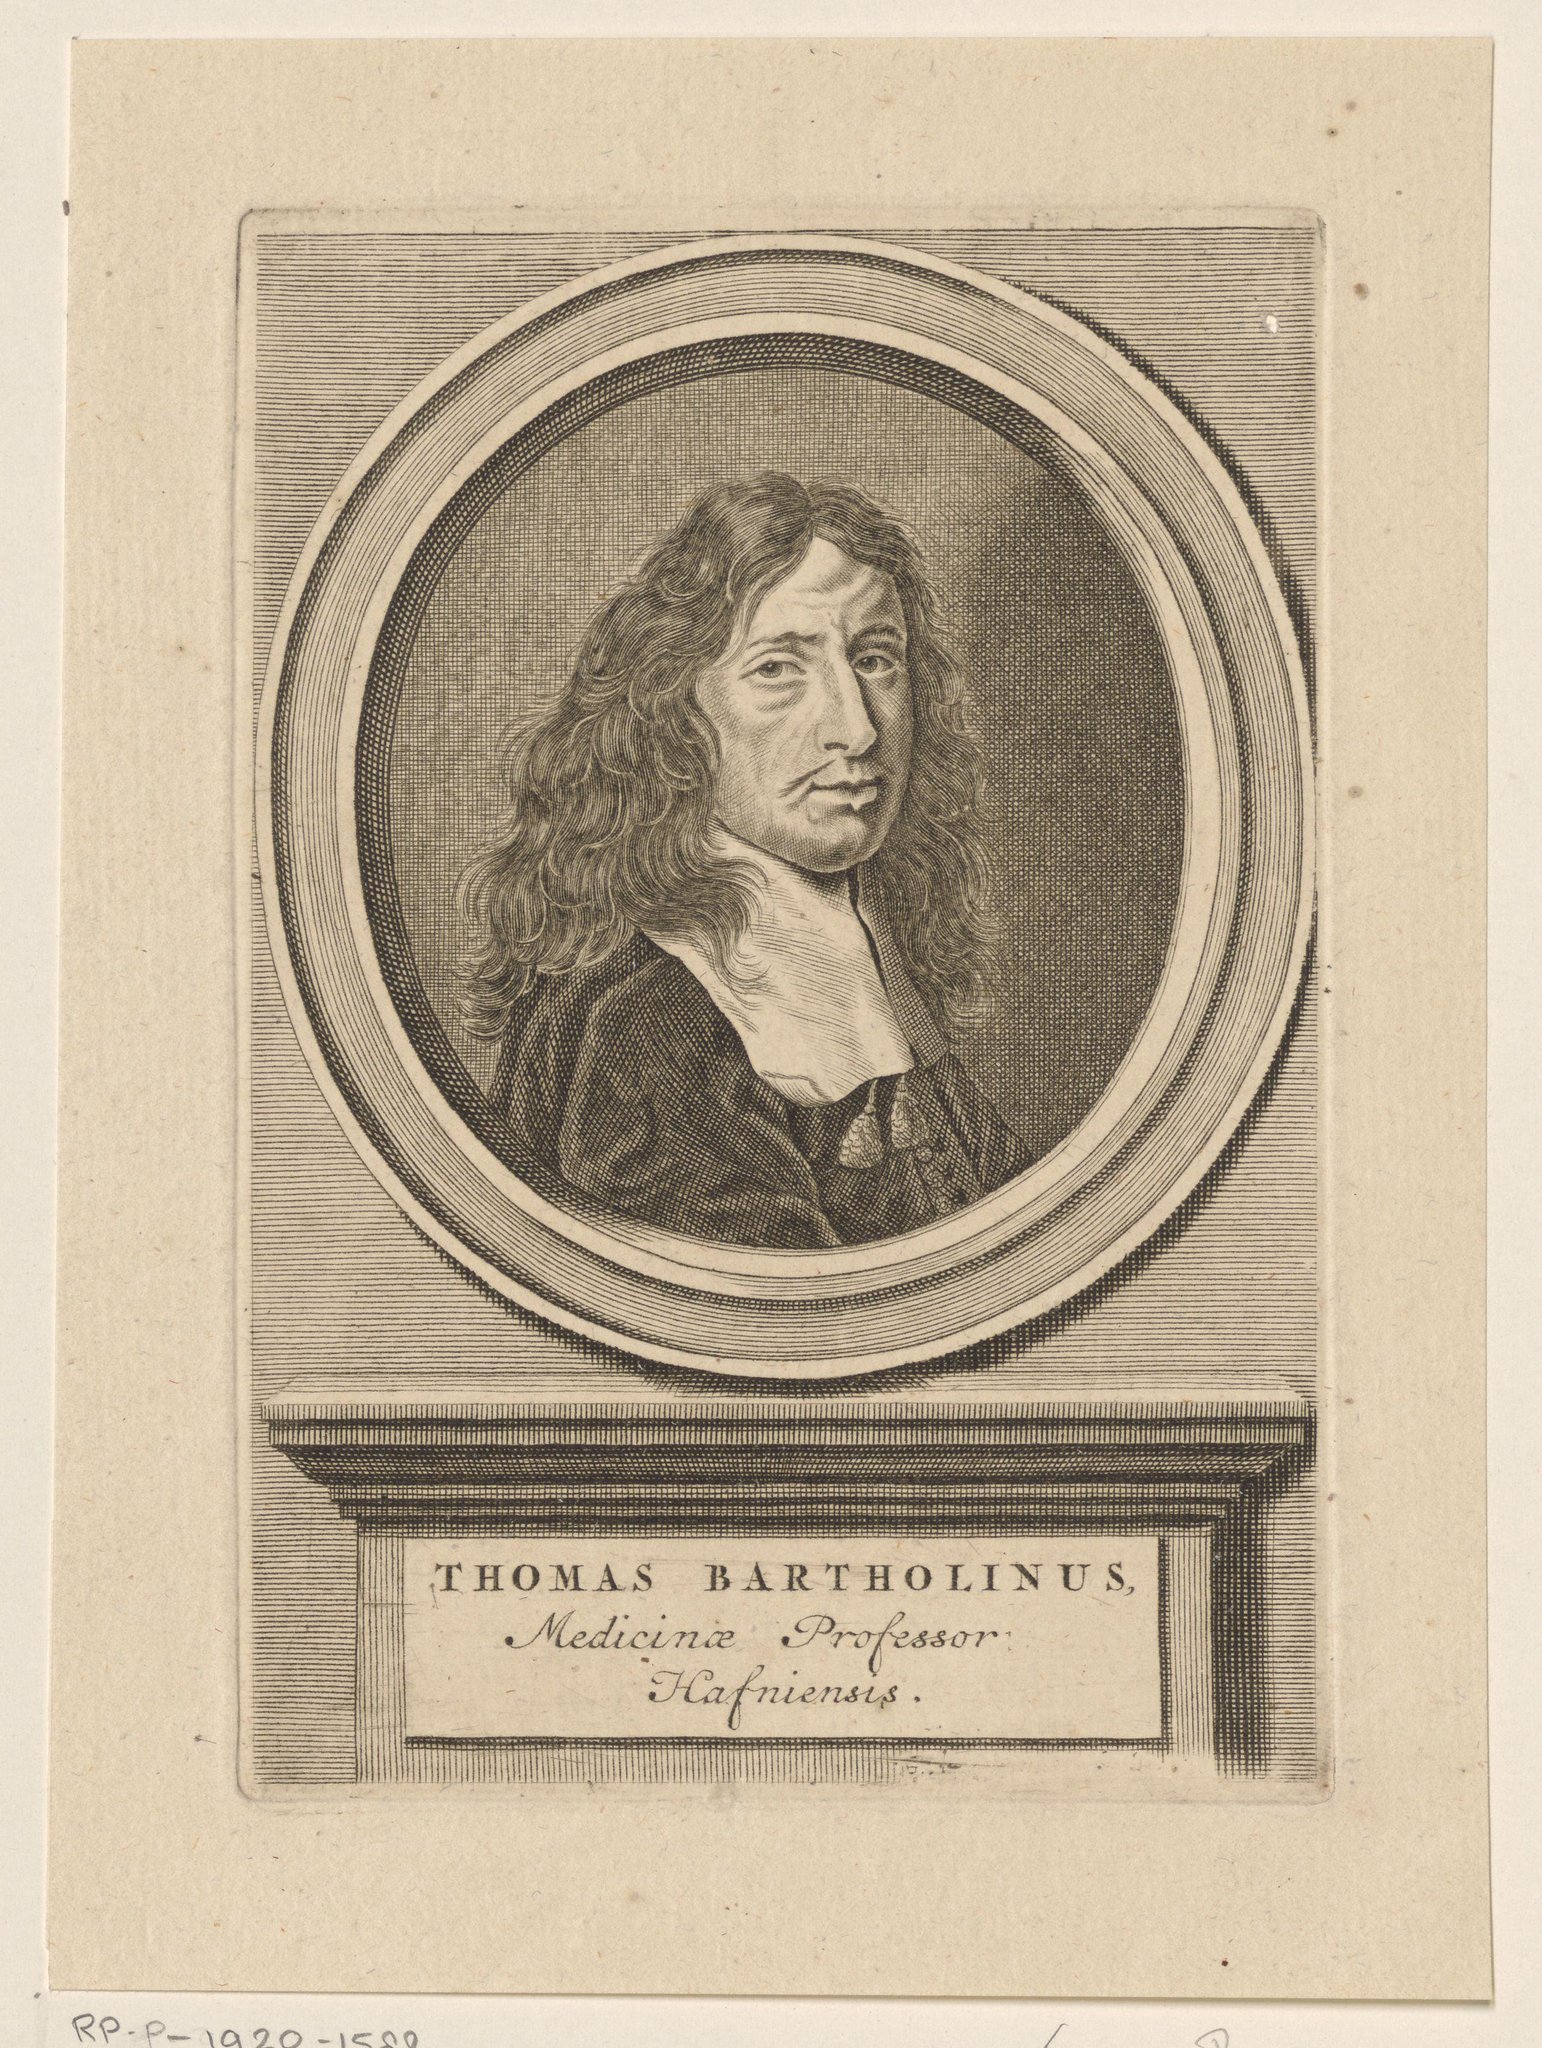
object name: print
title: Portret van Thomas Bartholin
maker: gonsales appelmans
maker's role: print maker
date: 1666-1683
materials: paper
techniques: engraving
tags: copenhagen (city), thomas bartholin, historical persons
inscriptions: collector's mark: Lugt 2228